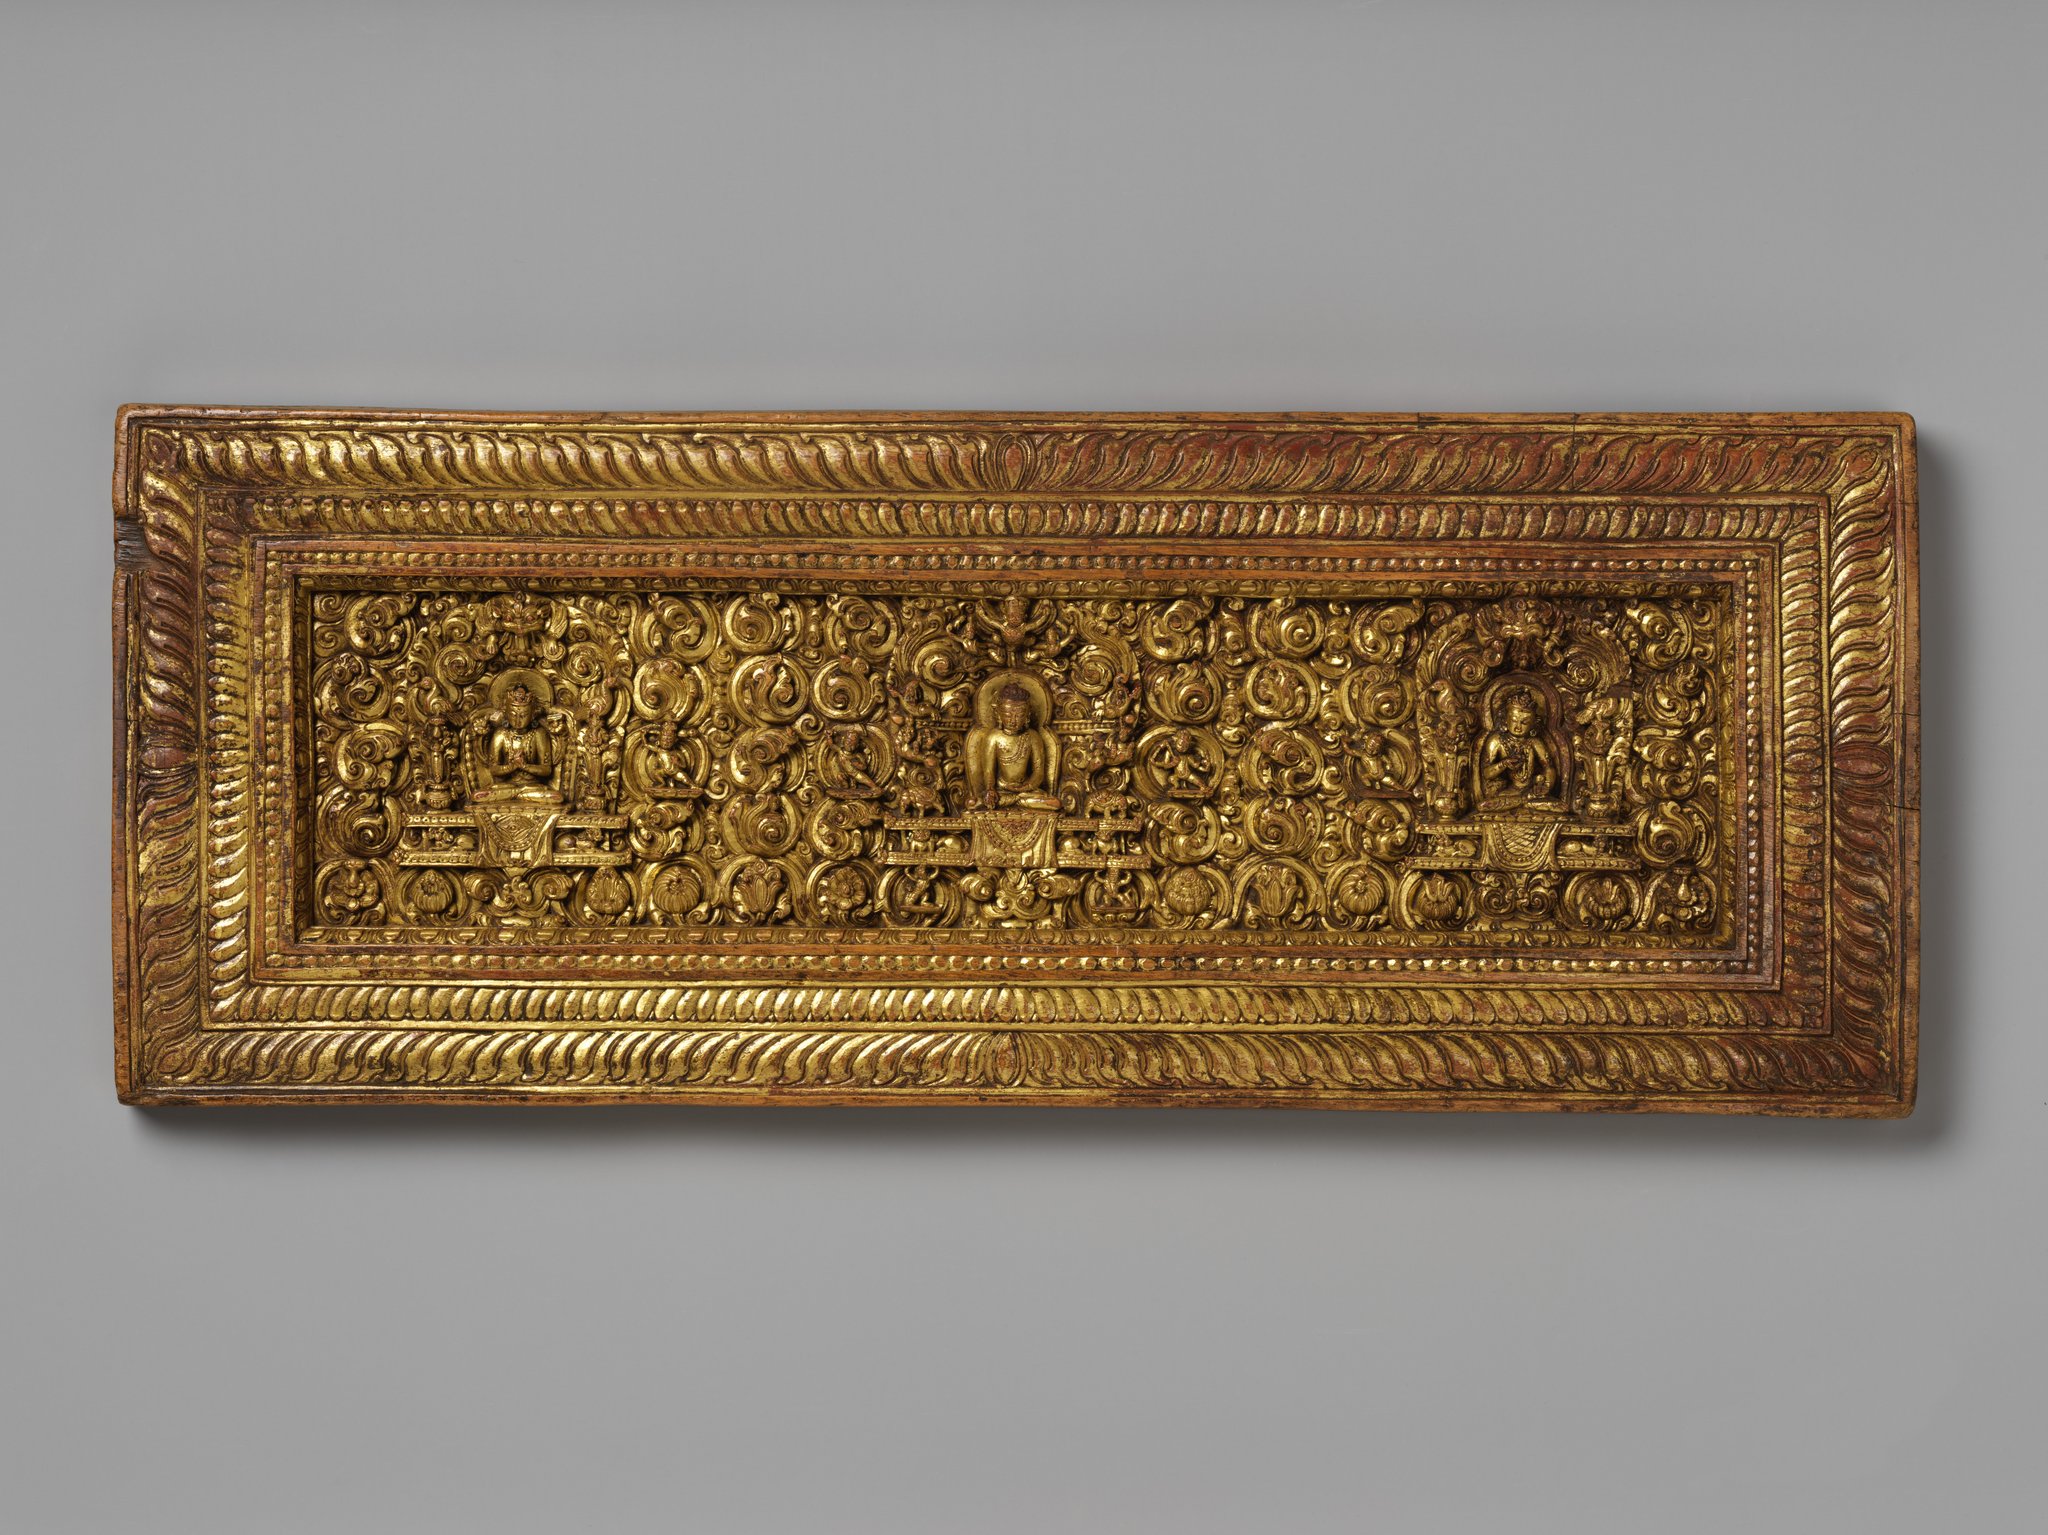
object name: manuscript cover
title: Manuscript Cover Interior with Mahasiddhas, Bodhisattvas, and Protectors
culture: tibetan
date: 1367-1400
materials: gold, wood